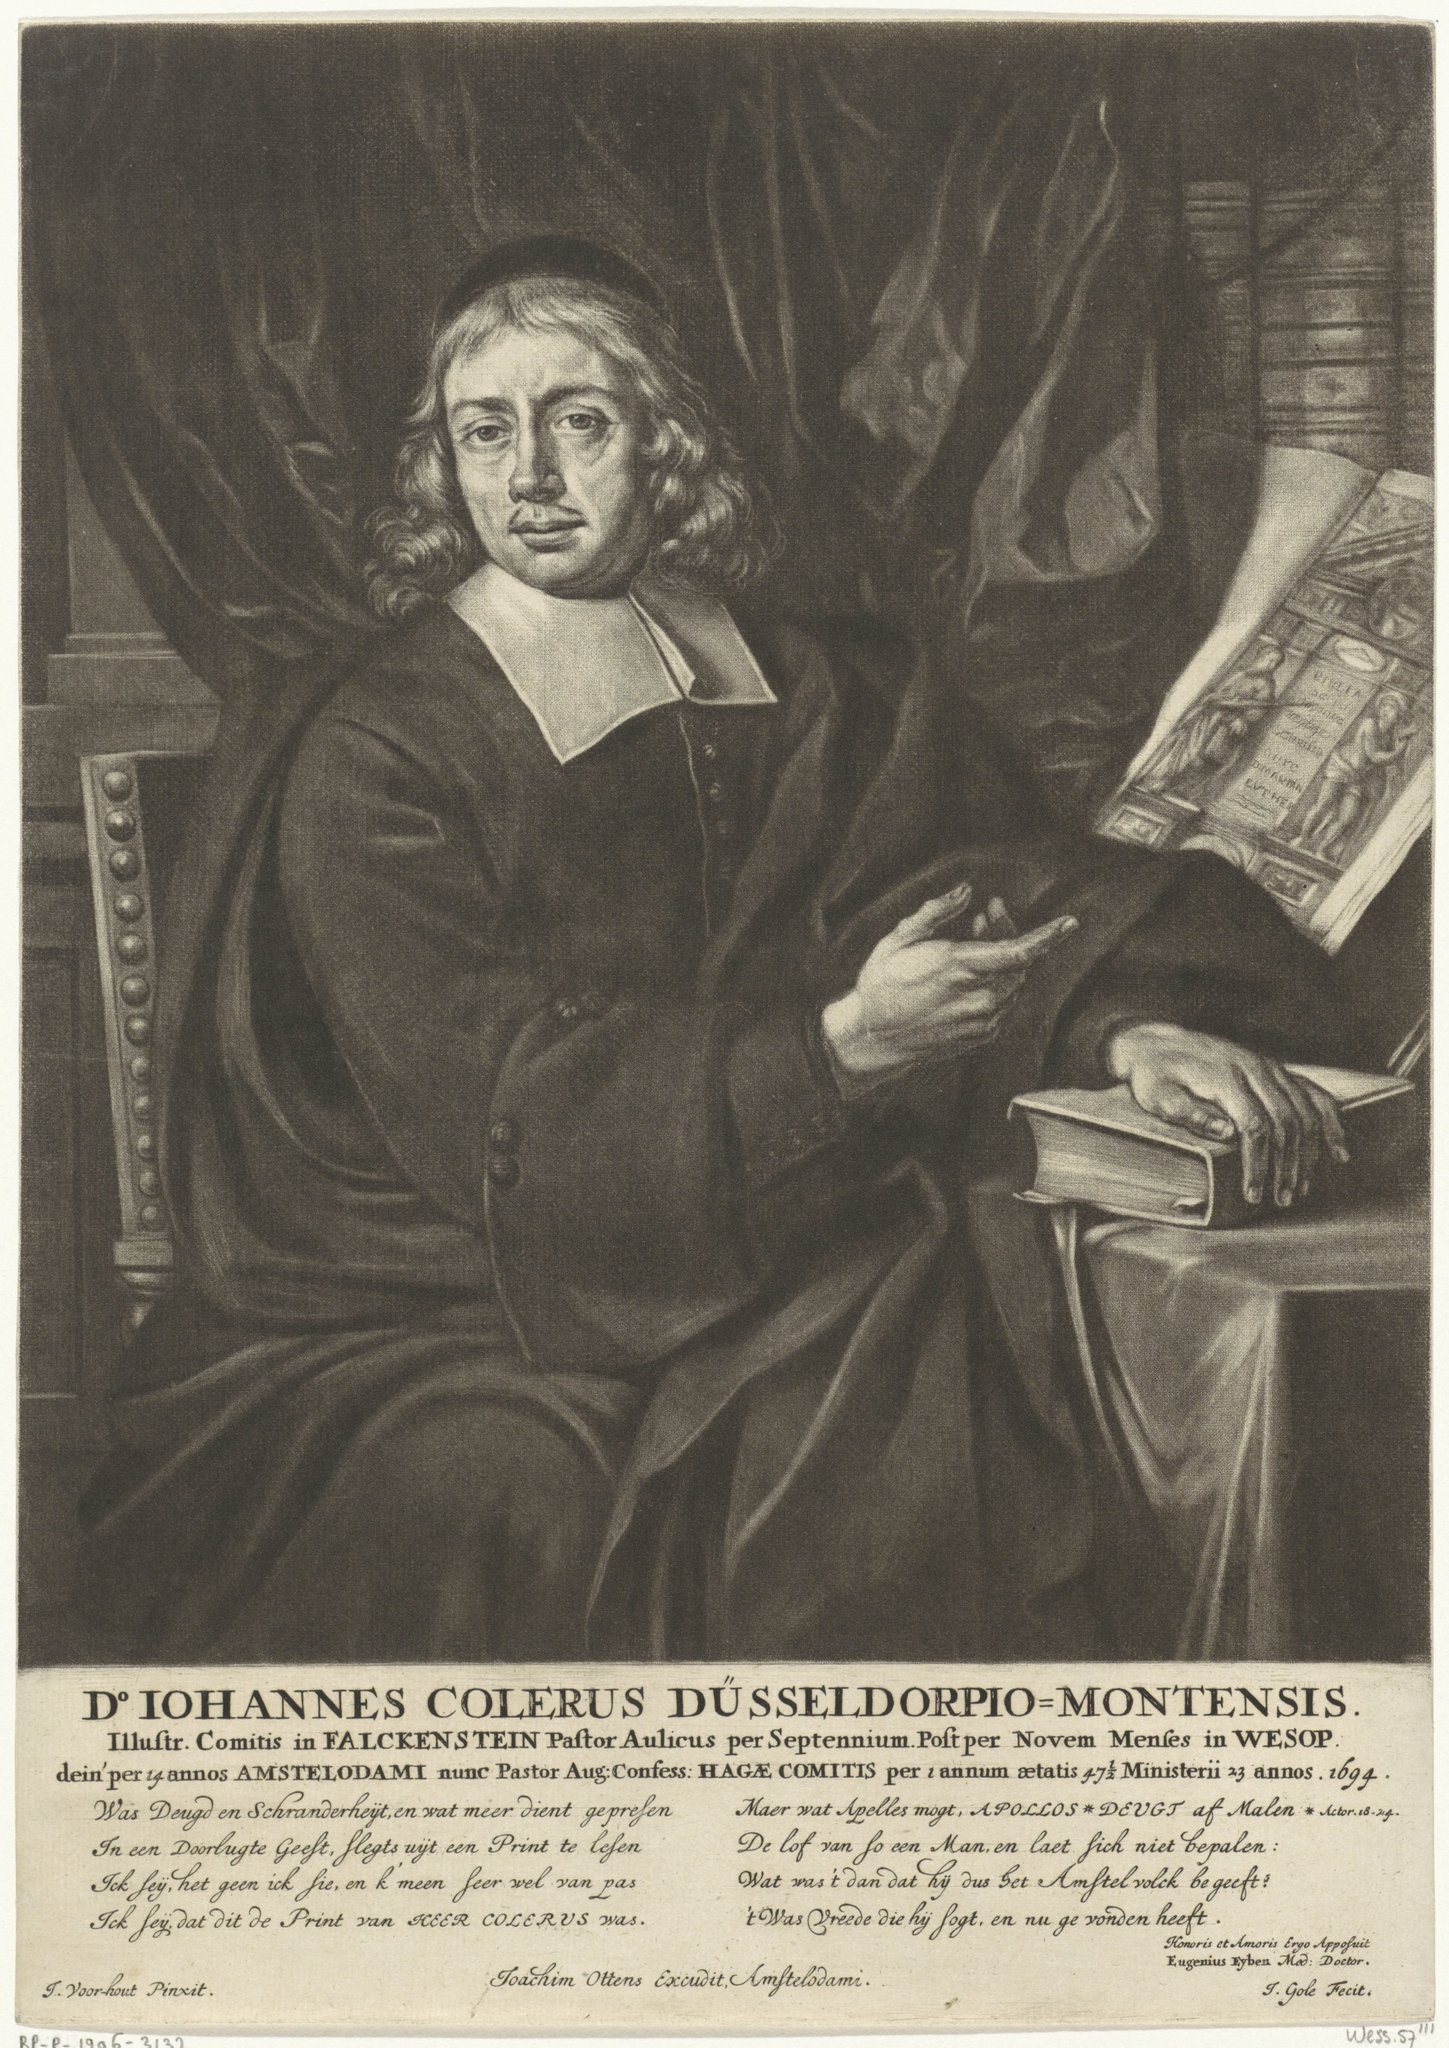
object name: print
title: Portret van Johannes Colerus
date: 1694-1724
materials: paper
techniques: engraving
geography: amsterdam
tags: johannes colerus (1647-1707), theologian, study; 'studiolo'; library, book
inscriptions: collector's mark: Lugt 2228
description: De schrijver en theoloog Johannes Colerus zittend aan een tafel en wijzend op een boek. In de marge zijn naam, titels en een lofdicht op zijn werk.